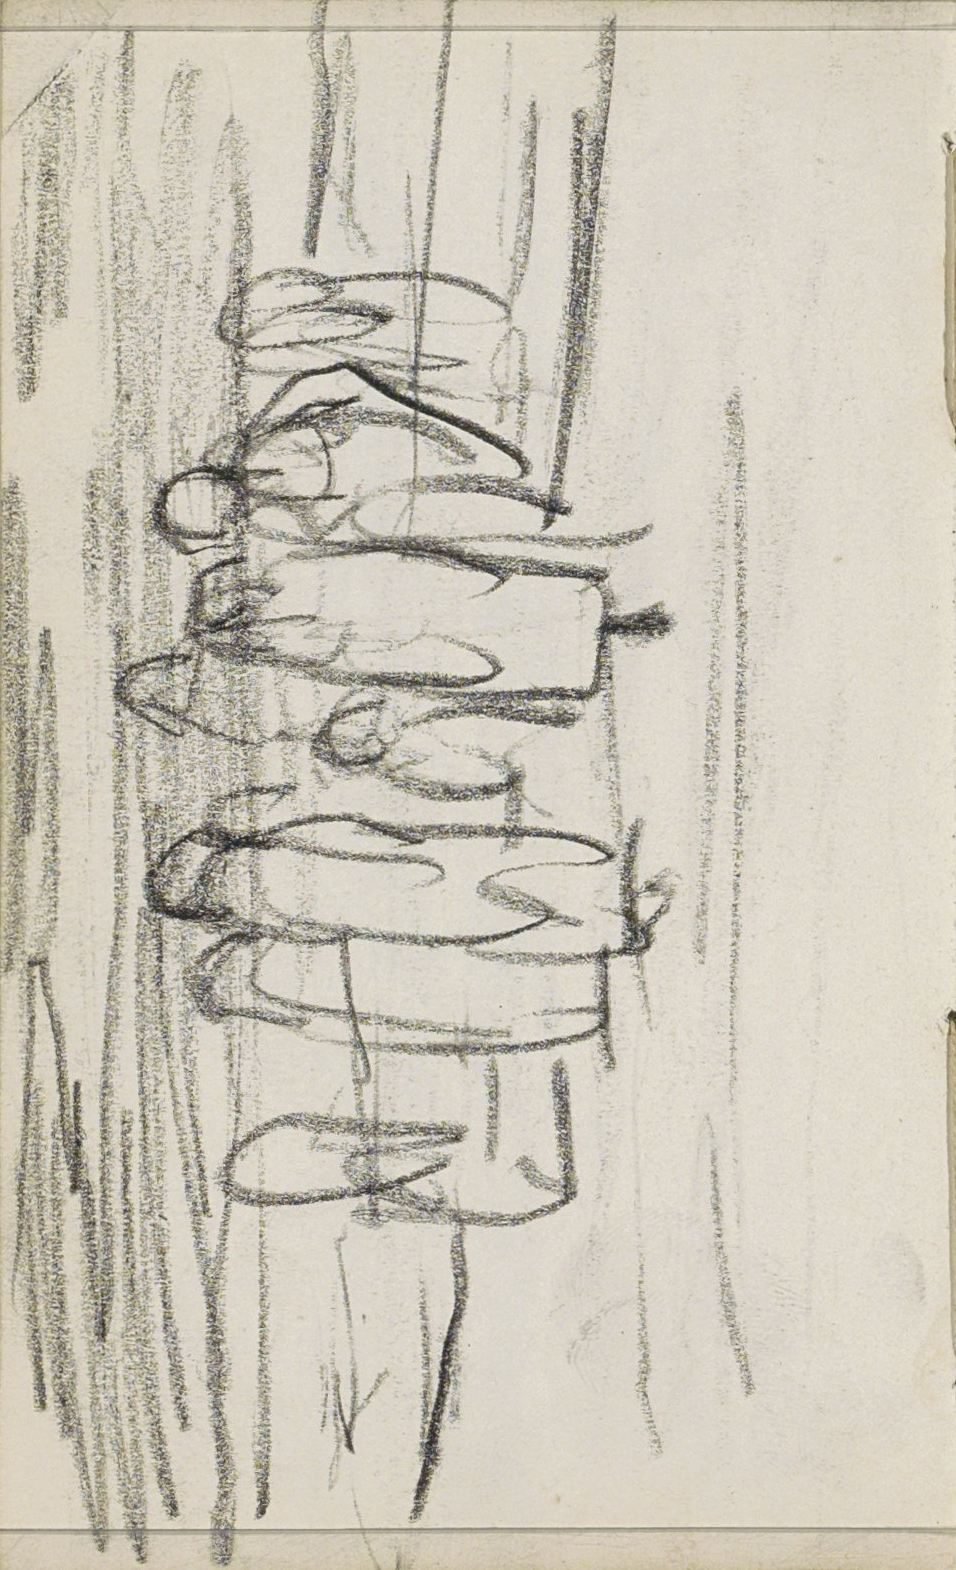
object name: sketchbook leaf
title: Groep staande figuren aan de vloedlijn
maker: anton mauve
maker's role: draughtsman, painter, print maker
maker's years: 1838-1888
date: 1848-1888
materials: chalk, paper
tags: in or beside the water (on the beach)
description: Blad 18 verso uit een schetsboek met 53 bladen.